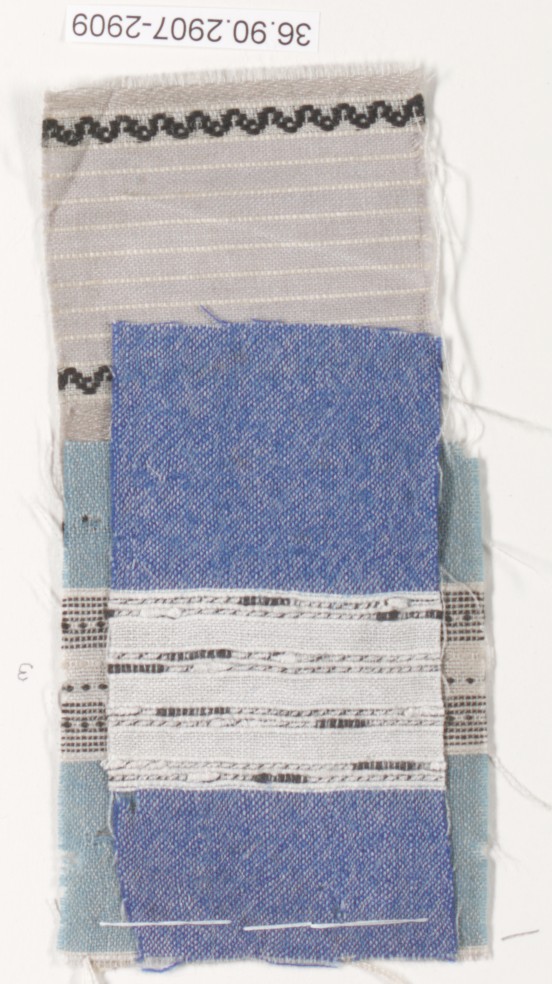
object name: piece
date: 1801-1900